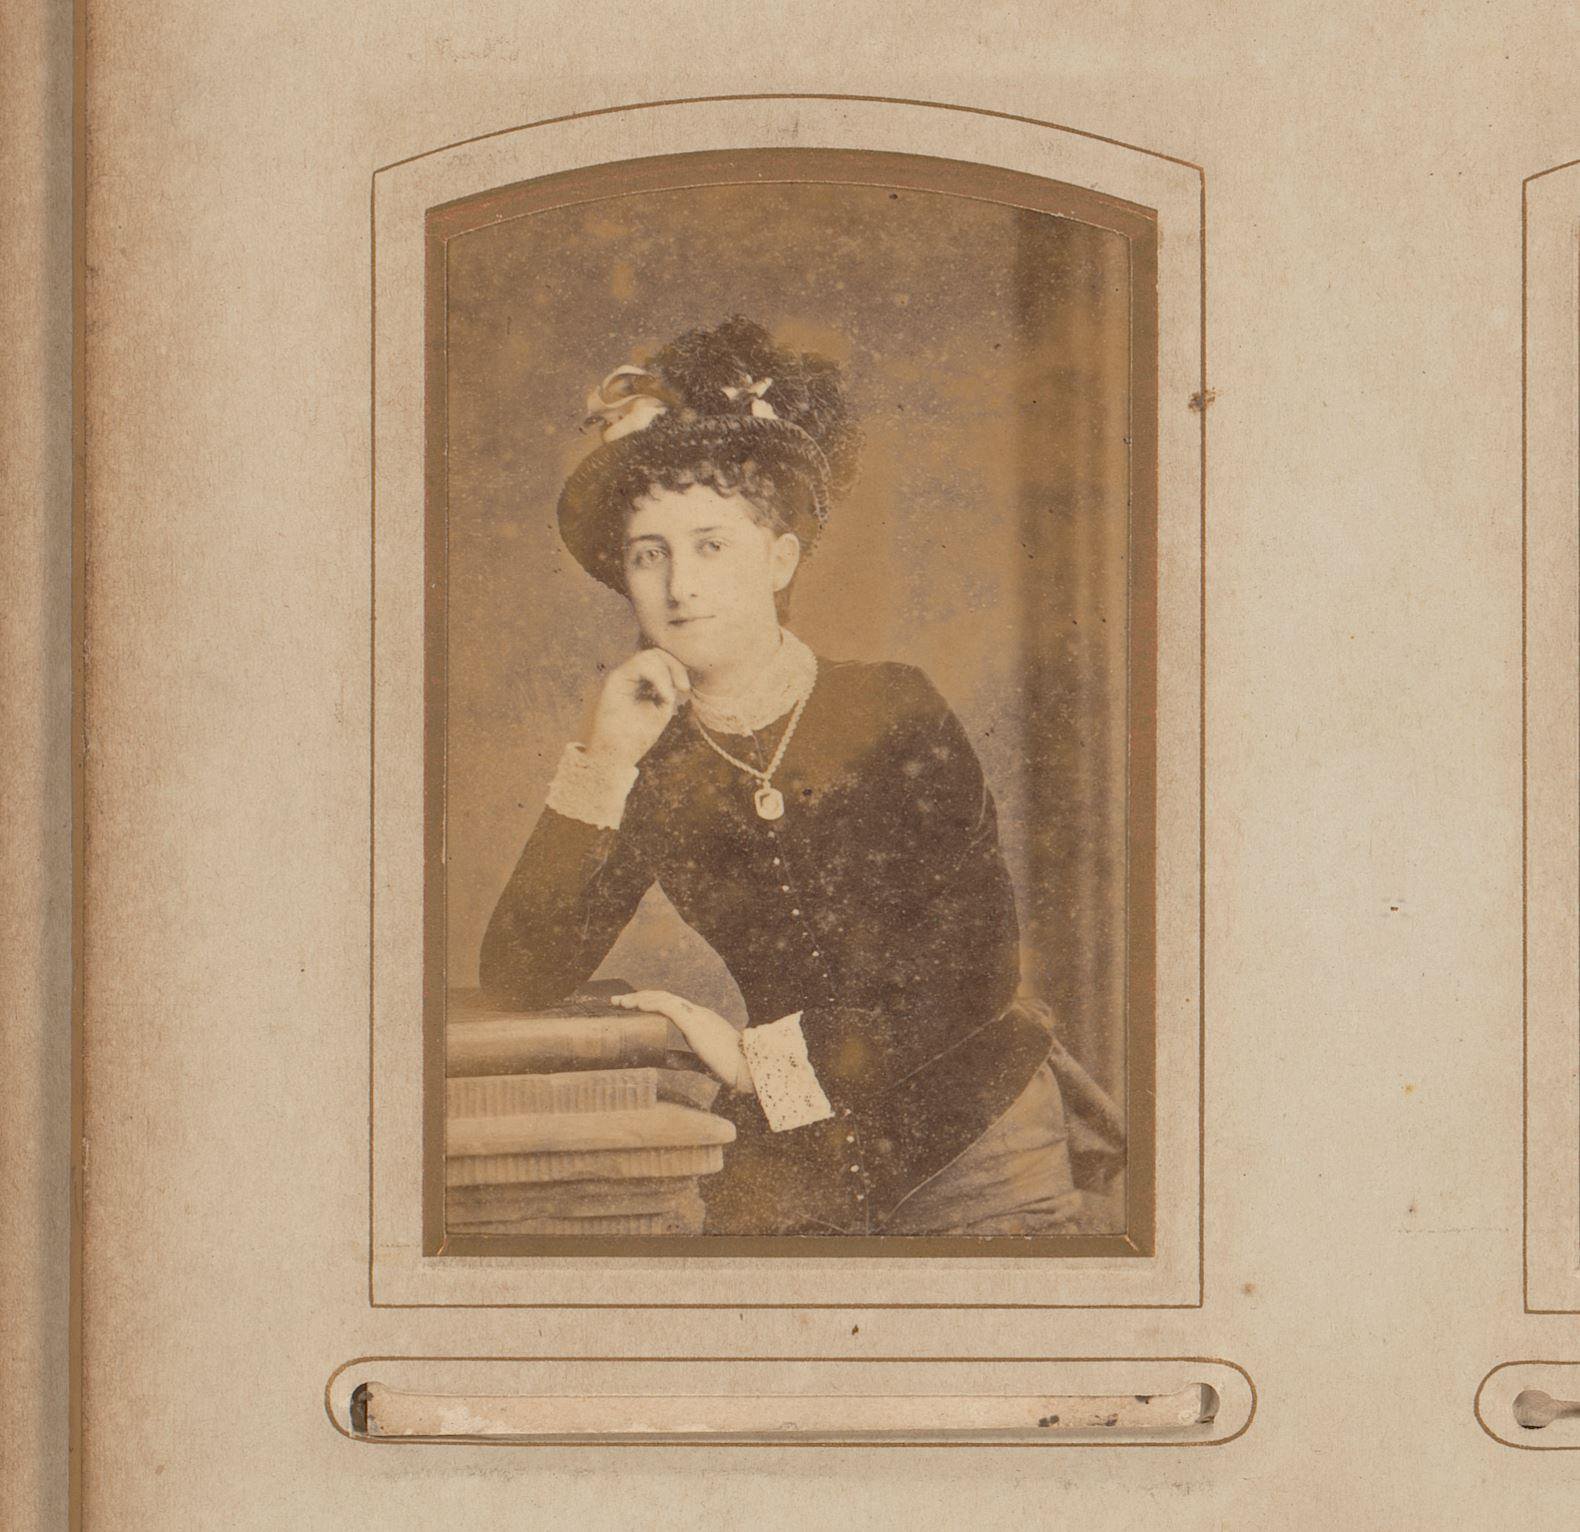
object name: photograph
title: Portret van een jonge vrouw met hoed, leunend op een zuil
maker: herman salzwedel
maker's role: fotograaf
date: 1880-1905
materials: cardboard, photographic support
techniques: albumen print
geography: surabaya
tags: adolescent, young woman, maiden, historical persons - bb - woman, head-gear: hat, pedestal of a piece of sculpture (perhaps in the form of a herm)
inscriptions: inscription: ‘(...)/ ATELIER/ van/ H. SALZWEDEL/ SOERABAYA/ JAVA.’